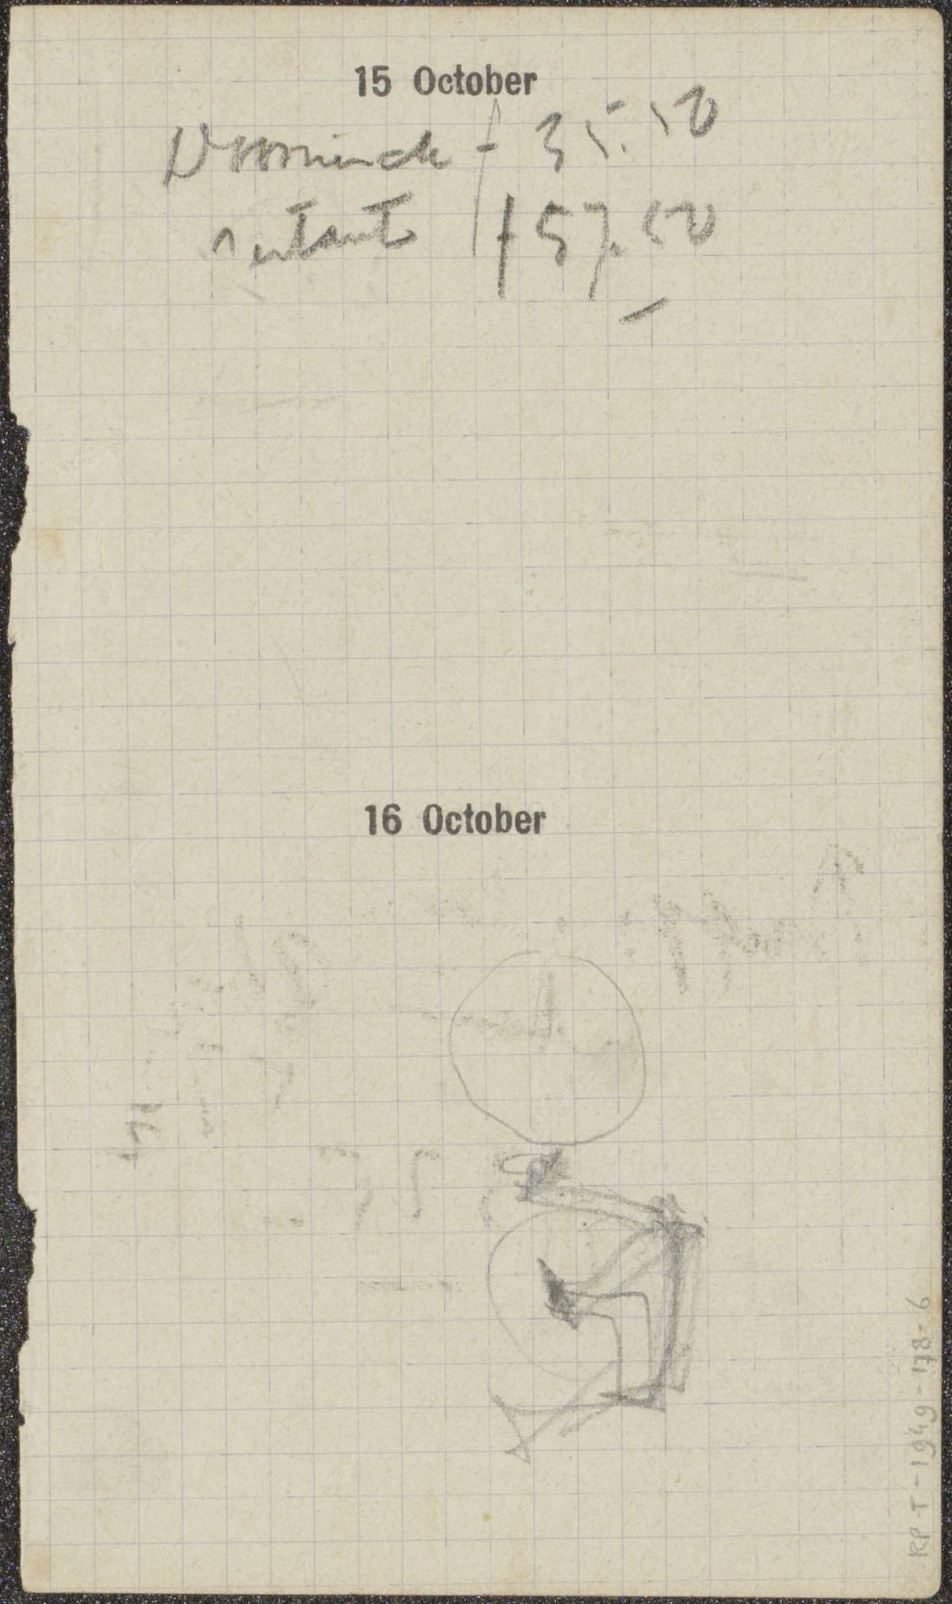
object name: drawing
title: Studie, mogelijk van twee wielen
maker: george hendrik breitner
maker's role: draughtsman, painter, print maker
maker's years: 1857-1923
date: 1873-1923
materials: pencil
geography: netherlands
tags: wheel (of vehicle)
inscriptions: annotation: ‘[...]’